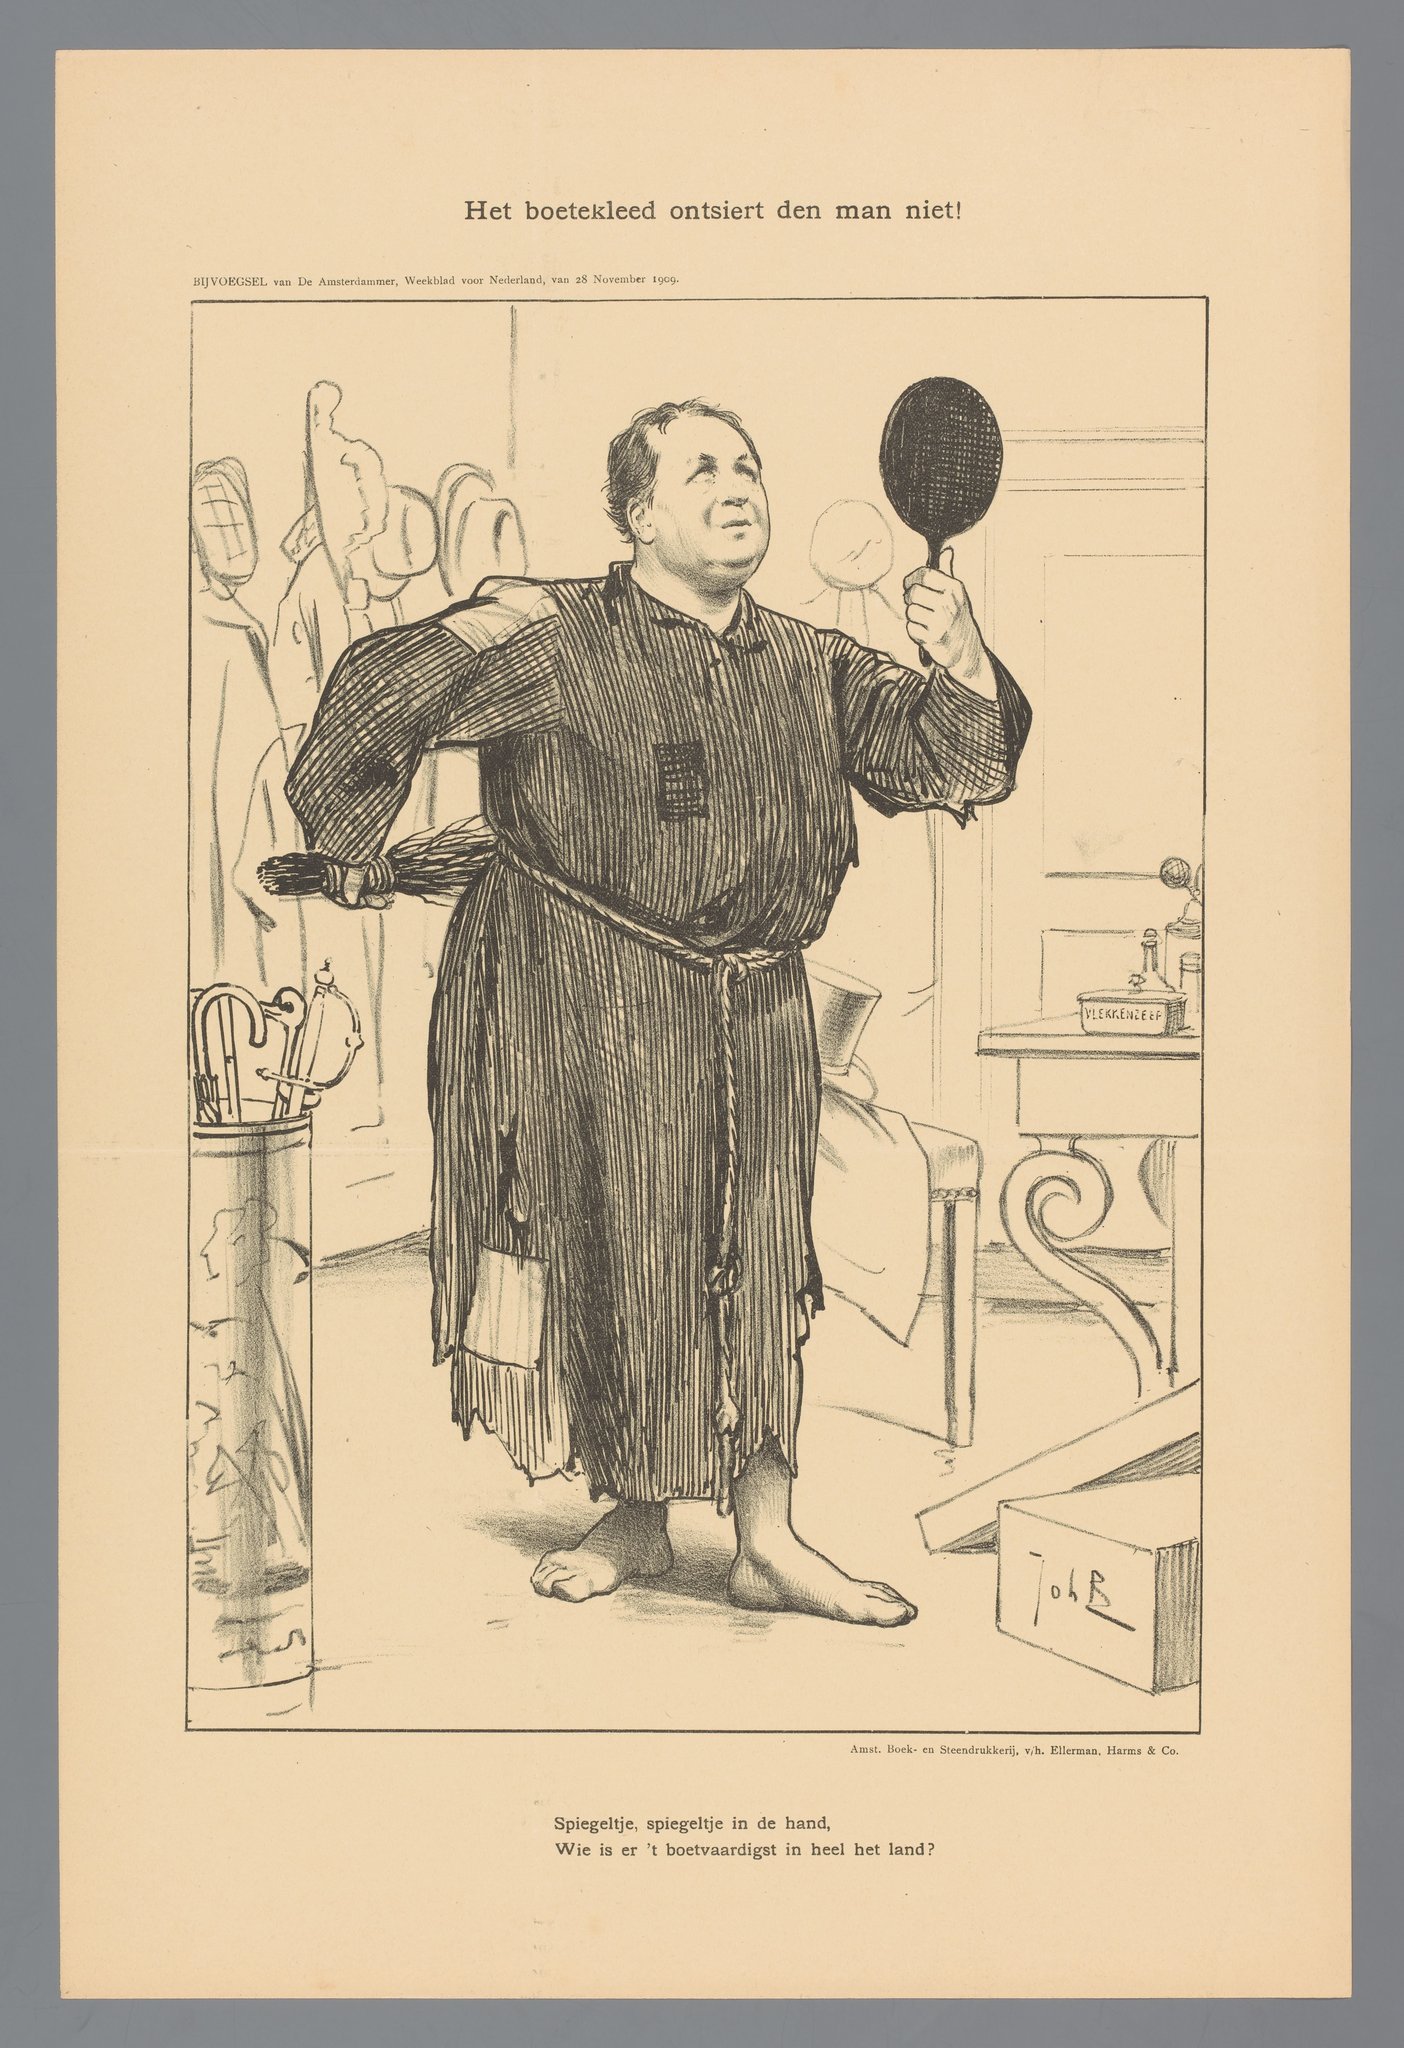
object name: cartoon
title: Het boetekleed ontsiert den man niet!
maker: johan braakensiek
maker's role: draughtsman, print maker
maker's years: 1858-1940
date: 1909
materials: paper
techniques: lithograph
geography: amsterdam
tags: abraham kuyper, looking in the mirror; contemplation of own beauty, self-castigation ~ ascetic life, political caricatures and satires, public penance, general avowal of faults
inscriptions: date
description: Prent uit het bijvoegsel van: De Amsterdammer. Weekblad voor Nederland, 28 november 1909.